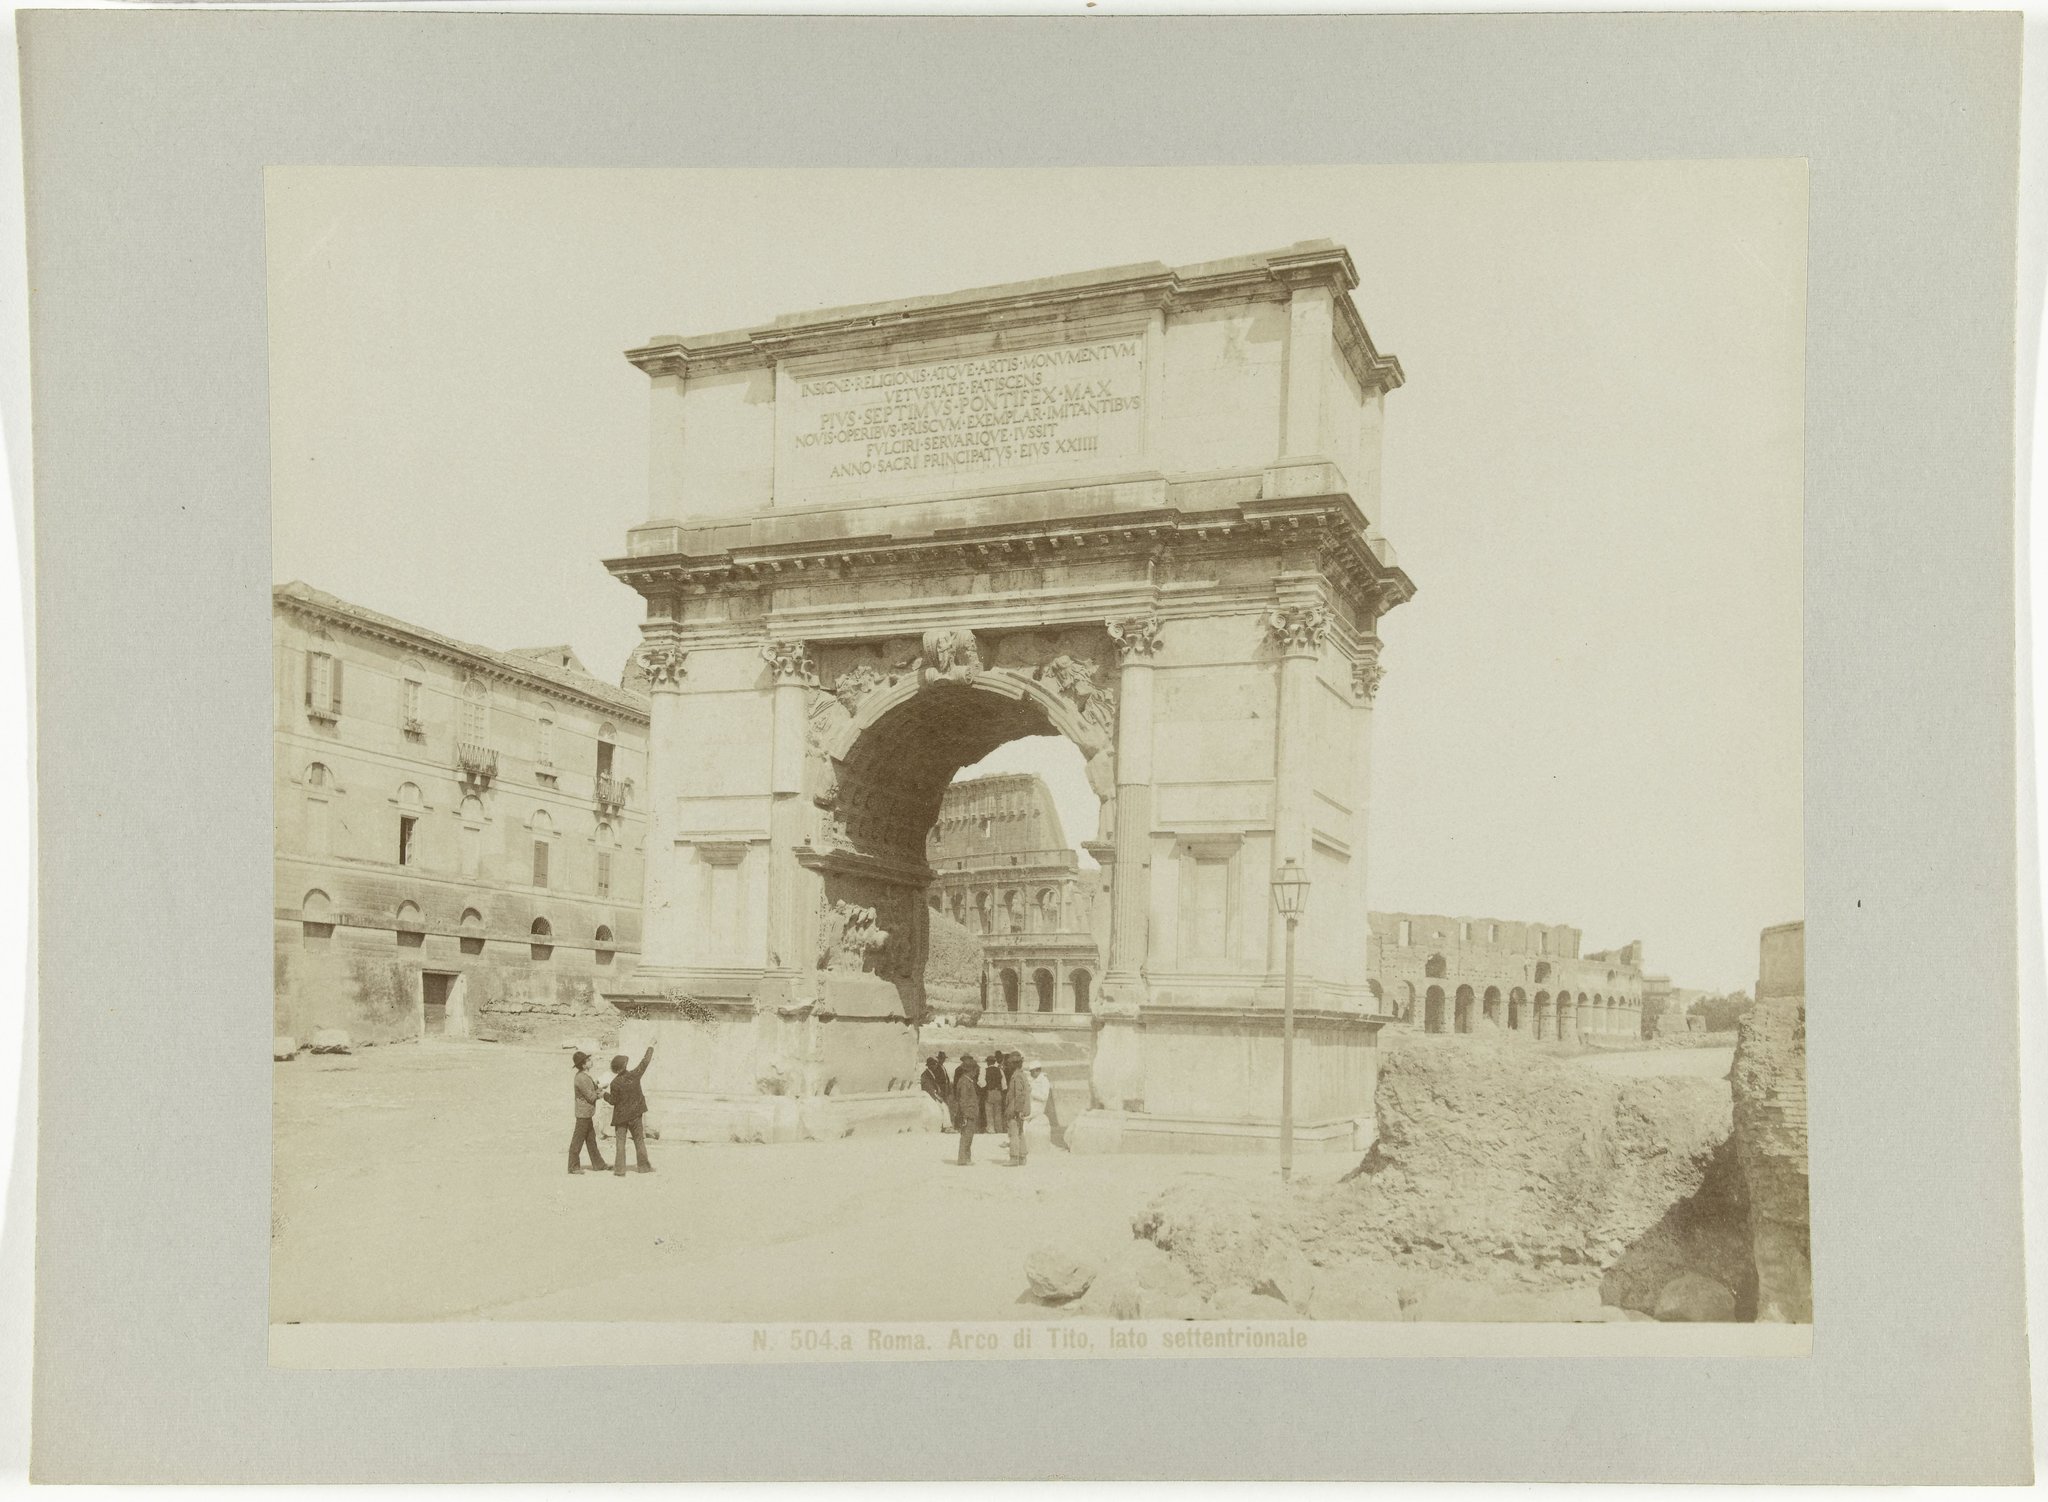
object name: photograph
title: N. 504.a Roma. Arco di Tito, lato settentrionale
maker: Anonymous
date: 1880-1904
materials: cardboard, paper, photographic support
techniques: albumen print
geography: rome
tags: boog van titus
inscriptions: number: ‘15.’